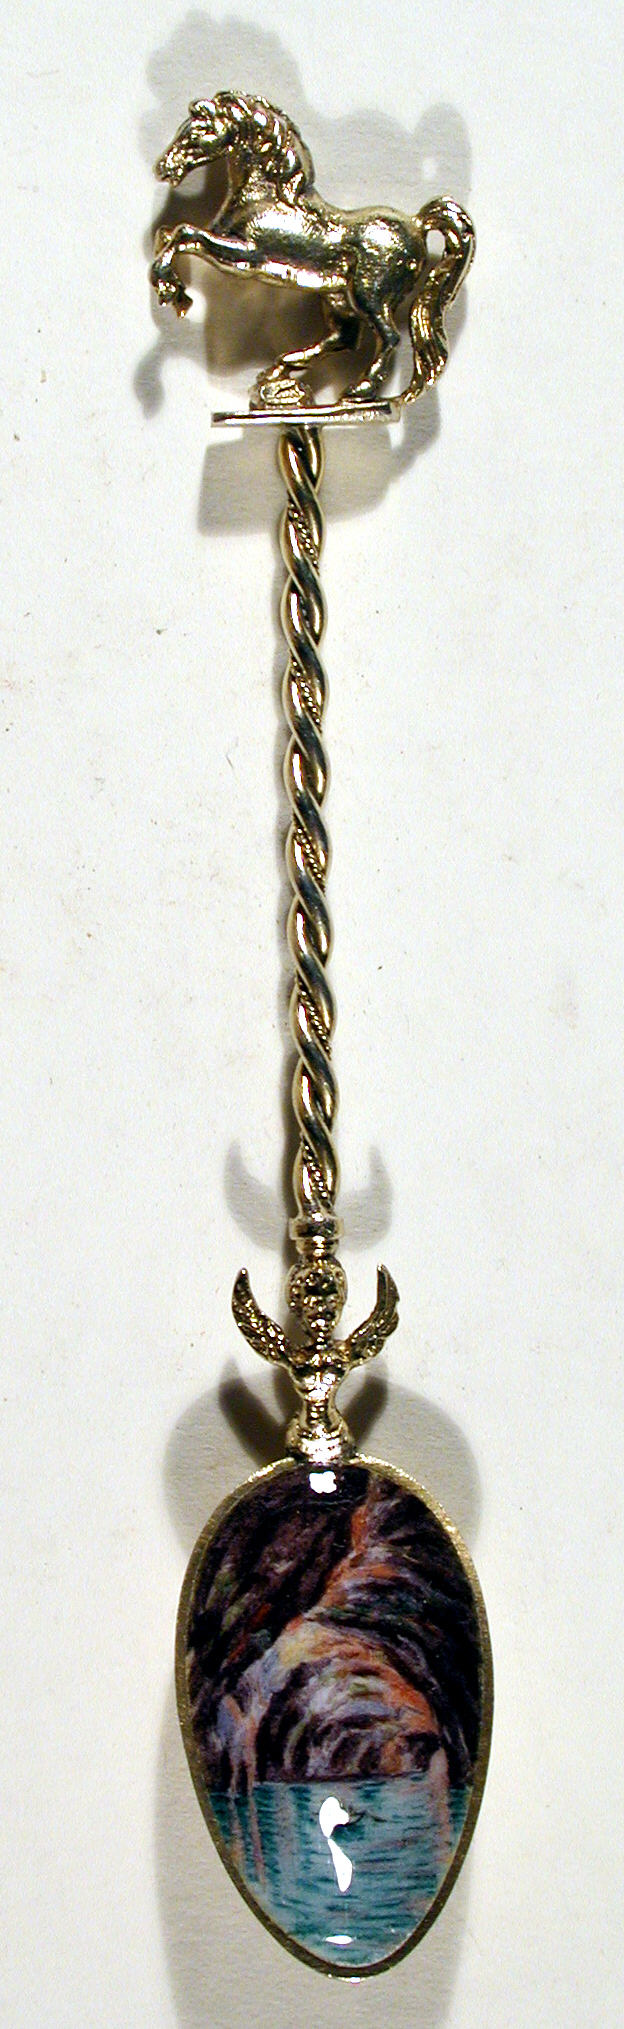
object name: souvenir spoon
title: Souvenir spoon with row boat in grotto with high ceiling of rocks at Capri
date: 1867-1900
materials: enamel, silver gilt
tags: horses